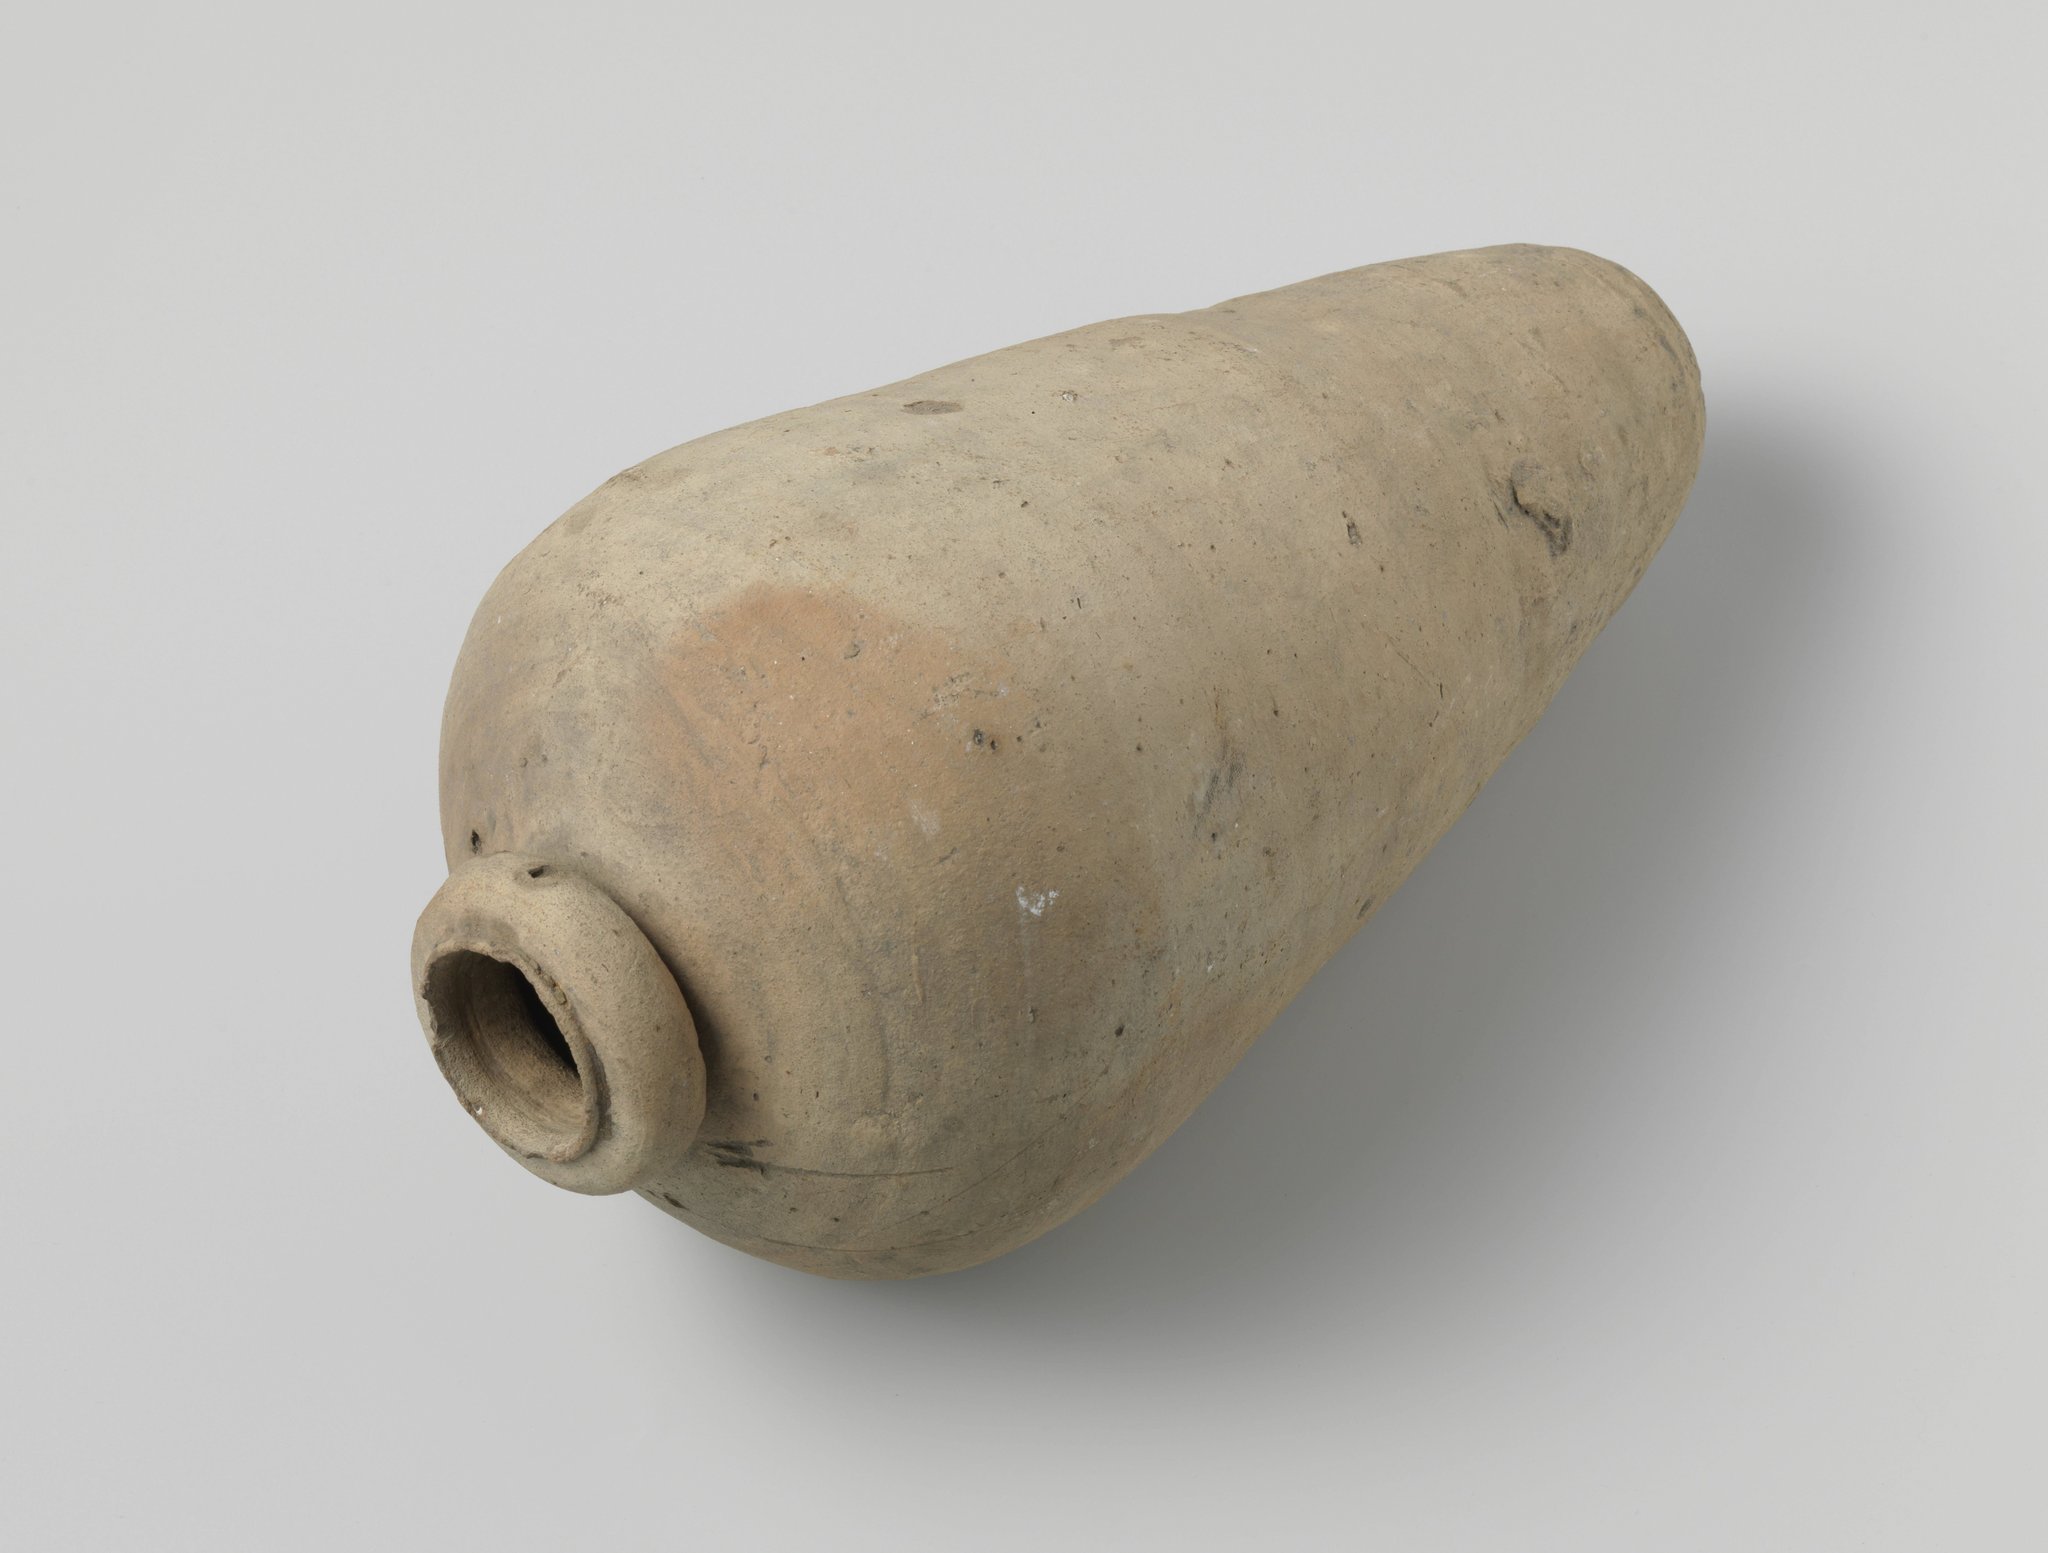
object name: pot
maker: Anonymous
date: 1600-1800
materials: earthenware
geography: france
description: Langwerpige, spits naar onderen toelopende pot van aardewerk. Bij de pot horen twee potten met invnr. BK-KOG-484 en BK-KOG-486. Alle drie de potten zijn bodemvondsten.